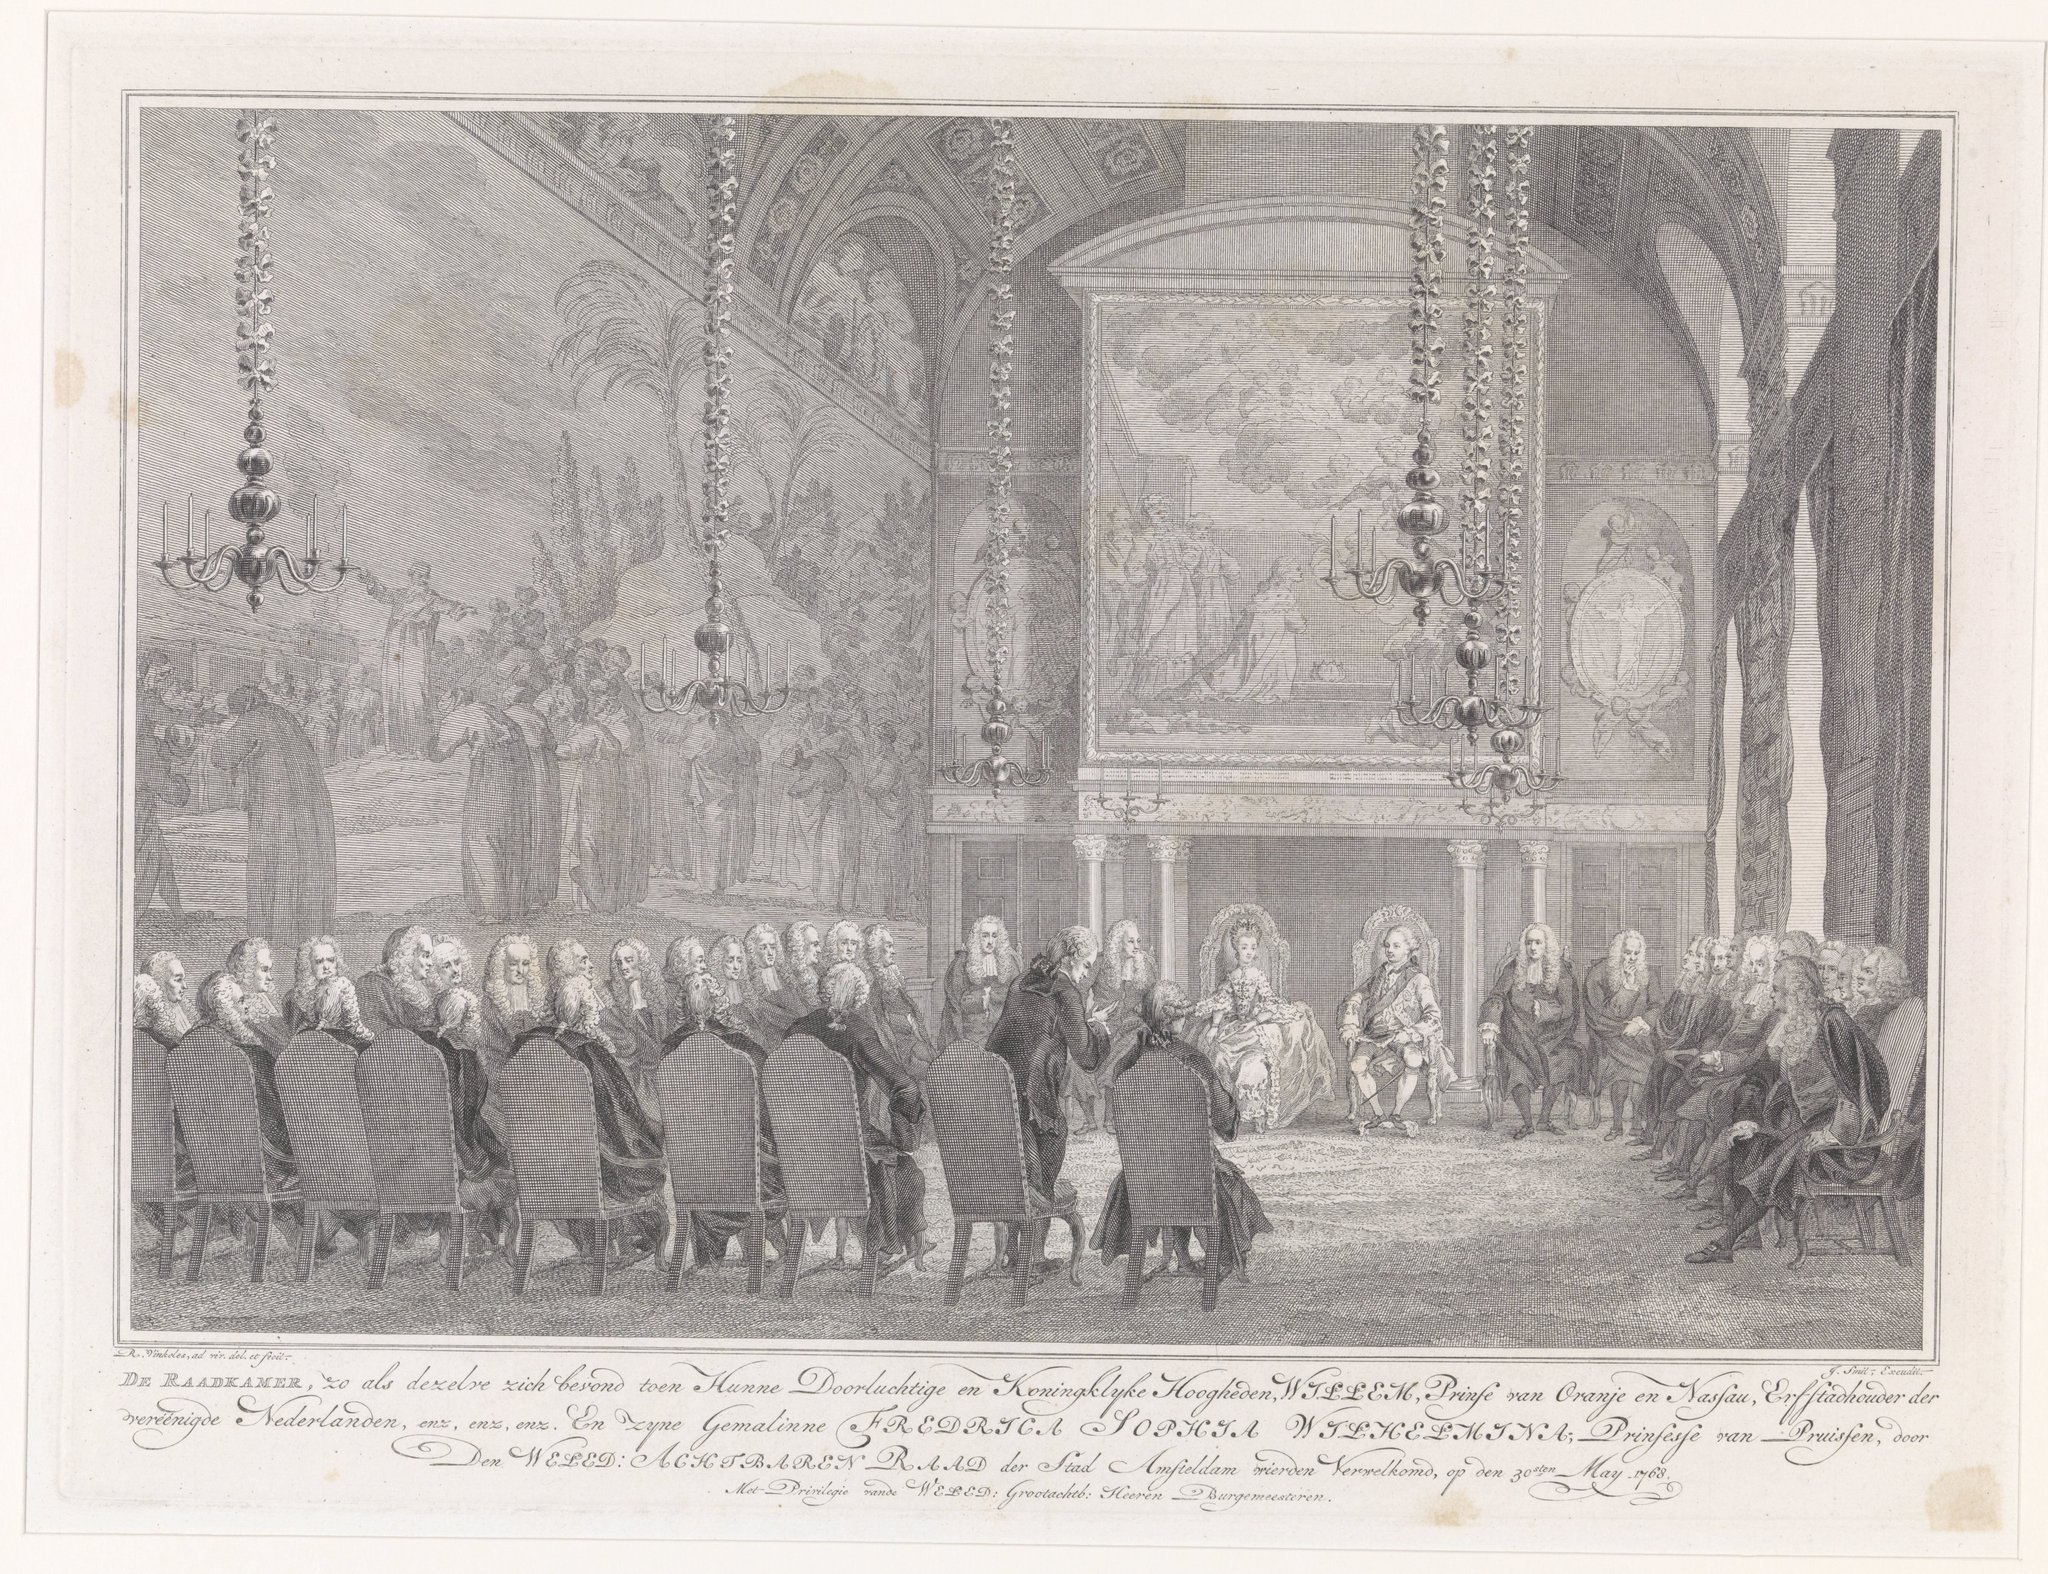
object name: print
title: Afbeelding der Vreugdebedryven en Plegtigheden die by de aankomst en gedurende het verblyf (...) Willem (...) en zyne Gemaalinne (...) zyn voorgevallen te Amsterdam, op maandag, den 30 Mey, en eenige volgende dagen, des jaars 1768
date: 1769-1773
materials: paper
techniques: engraving, etching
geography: northern netherlands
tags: the hague, william v (prince of orange), wilhelmina of prussia (princess of orange), triumphal entry and public reception, pageant, 'entrée solennelle', 'joyeuse entrée'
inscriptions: collector's mark: Lugt 2228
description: Ontvangst van stadhouder Willem V en prinses Wilhelmina van Pruisen door de Raad in de vroedschapskamer in het stadhuis op de Dam te Amsterdam, op 30 mei 1768. Onderdeel van een prentserie met titelprent en 14 platen van de inhaling van de prins en prinses te Amsterdam, 30 mei - 4 juni 1768.